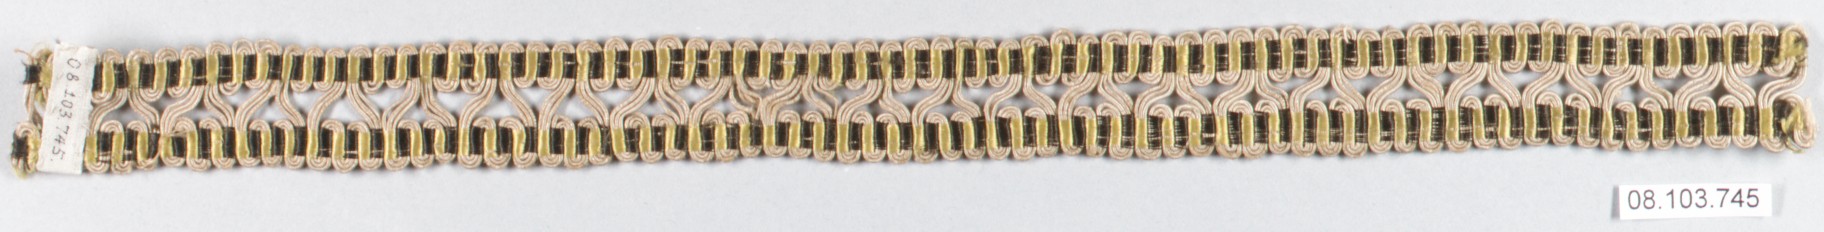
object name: gimp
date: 1701-1900